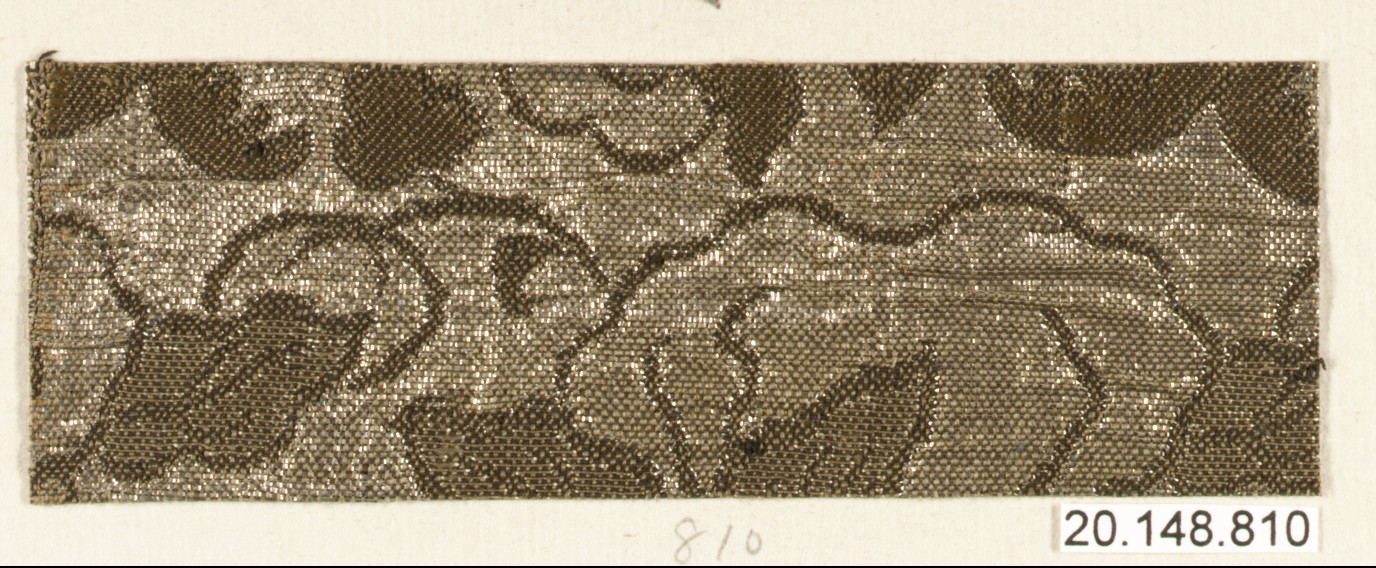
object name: piece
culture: japanese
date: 1701-1800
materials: silk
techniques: compound weave